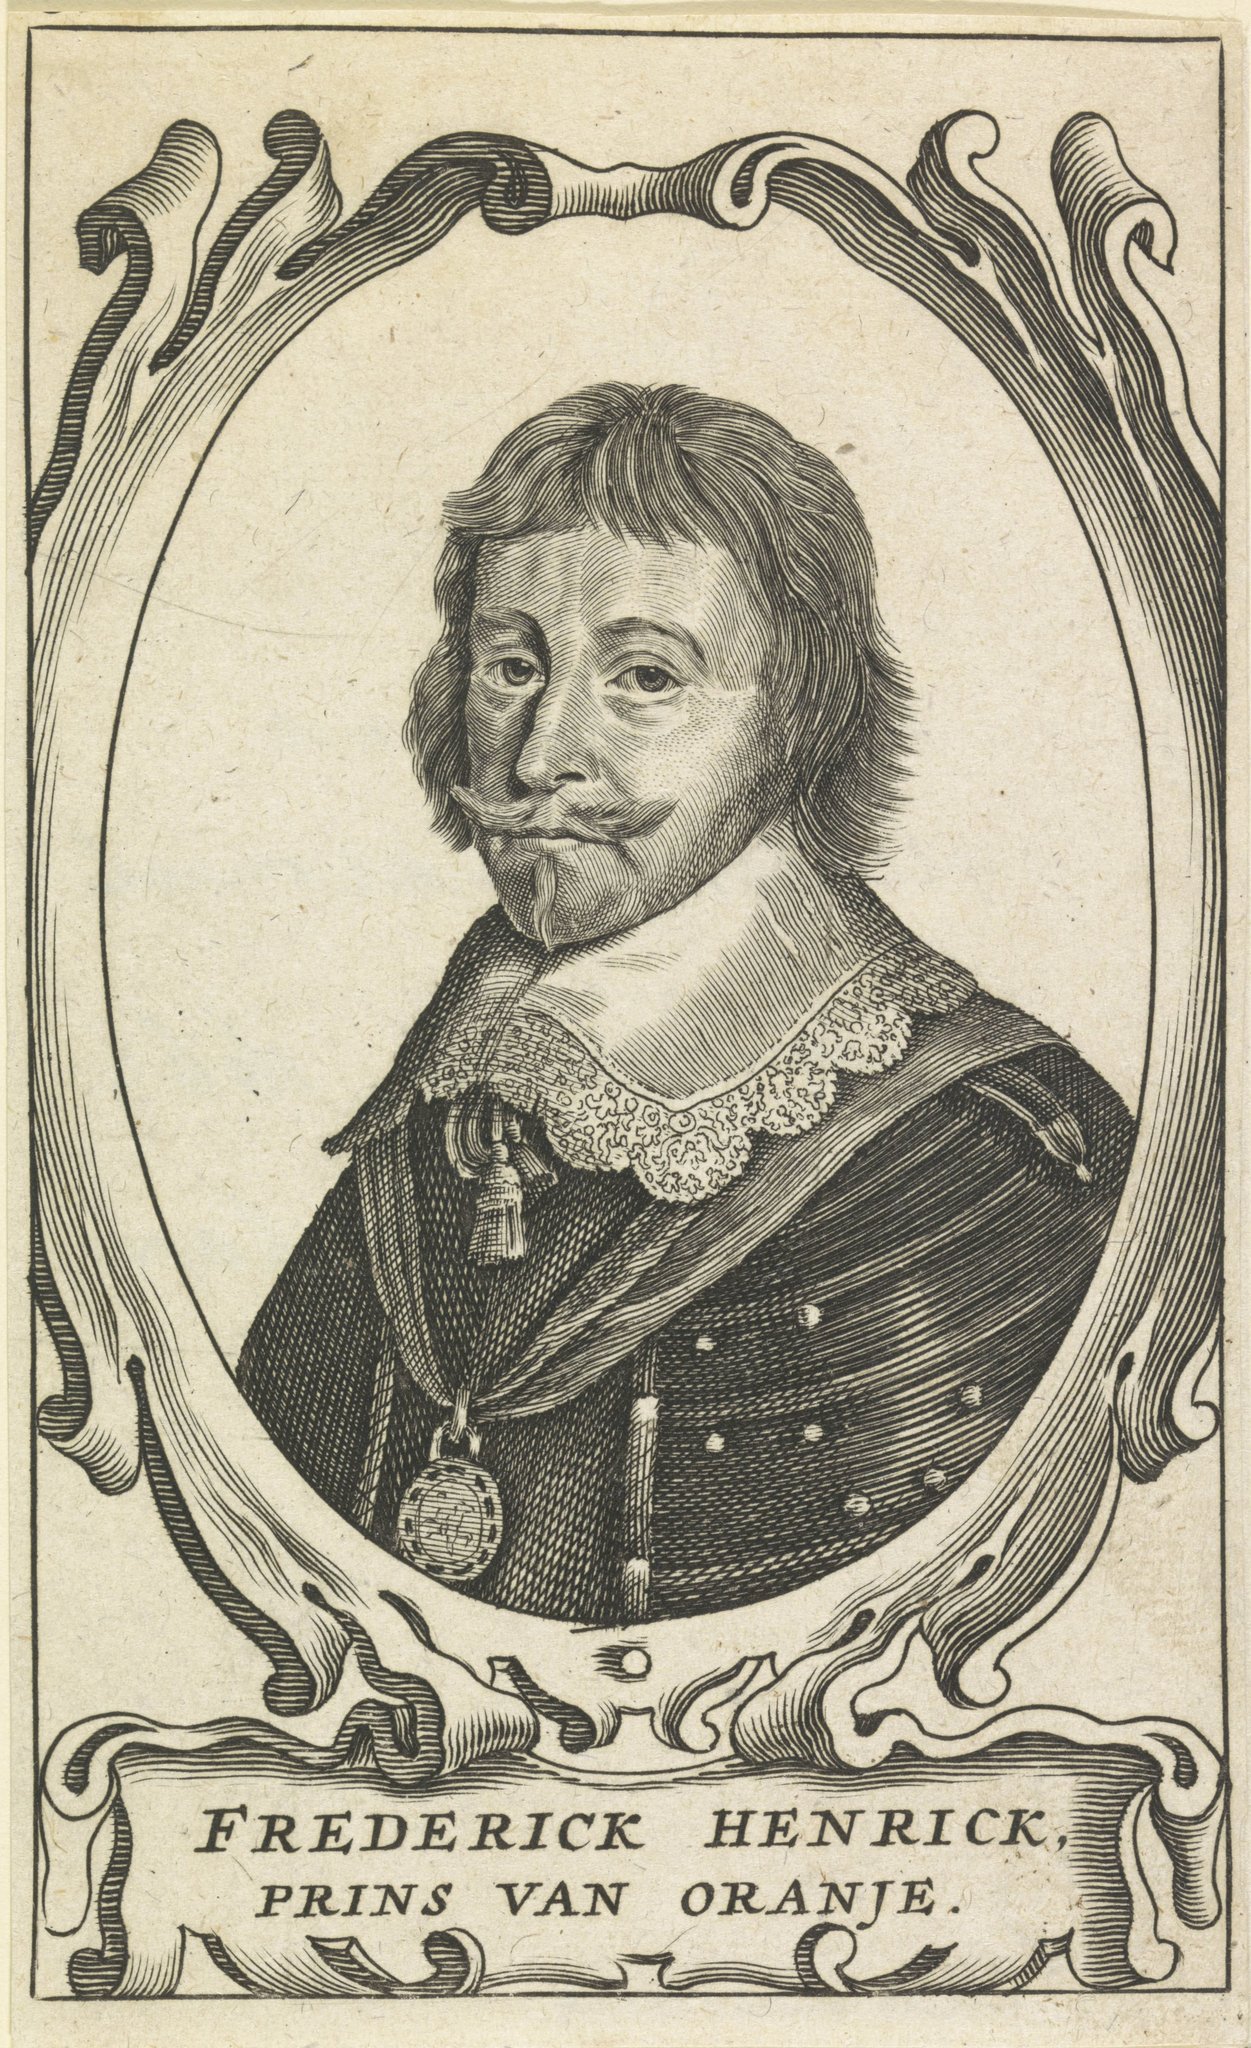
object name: print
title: Portret van Frederik Hendrik, prins van Oranje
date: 1663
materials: paper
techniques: engraving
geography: low countries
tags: delft, the hague, frederick henry (prince of orange), knighthood order (garter) - insignia of a knighthood order, e.g.: badge, chain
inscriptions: collector's mark: Lugt 963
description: De hier vermelde titel verwijst naar de hoogst verkregen titel van de geportretteerde, niet per se naar de titel die de geportretteerde op deze voorstelling draagt. Prent uit: Nassouser heldens pronk-toonneel opgetooydt, en volcierdt met de keurlĳkste helden van Nassou en Oranje. Amsterdam: Jacob van Meurs, 1663.